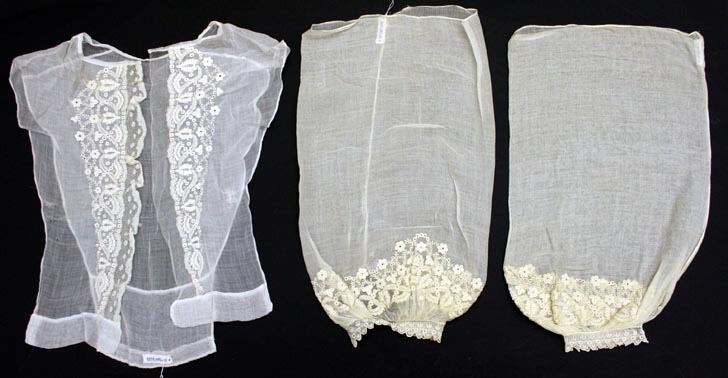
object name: accessory set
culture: american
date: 1855-1865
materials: cotton